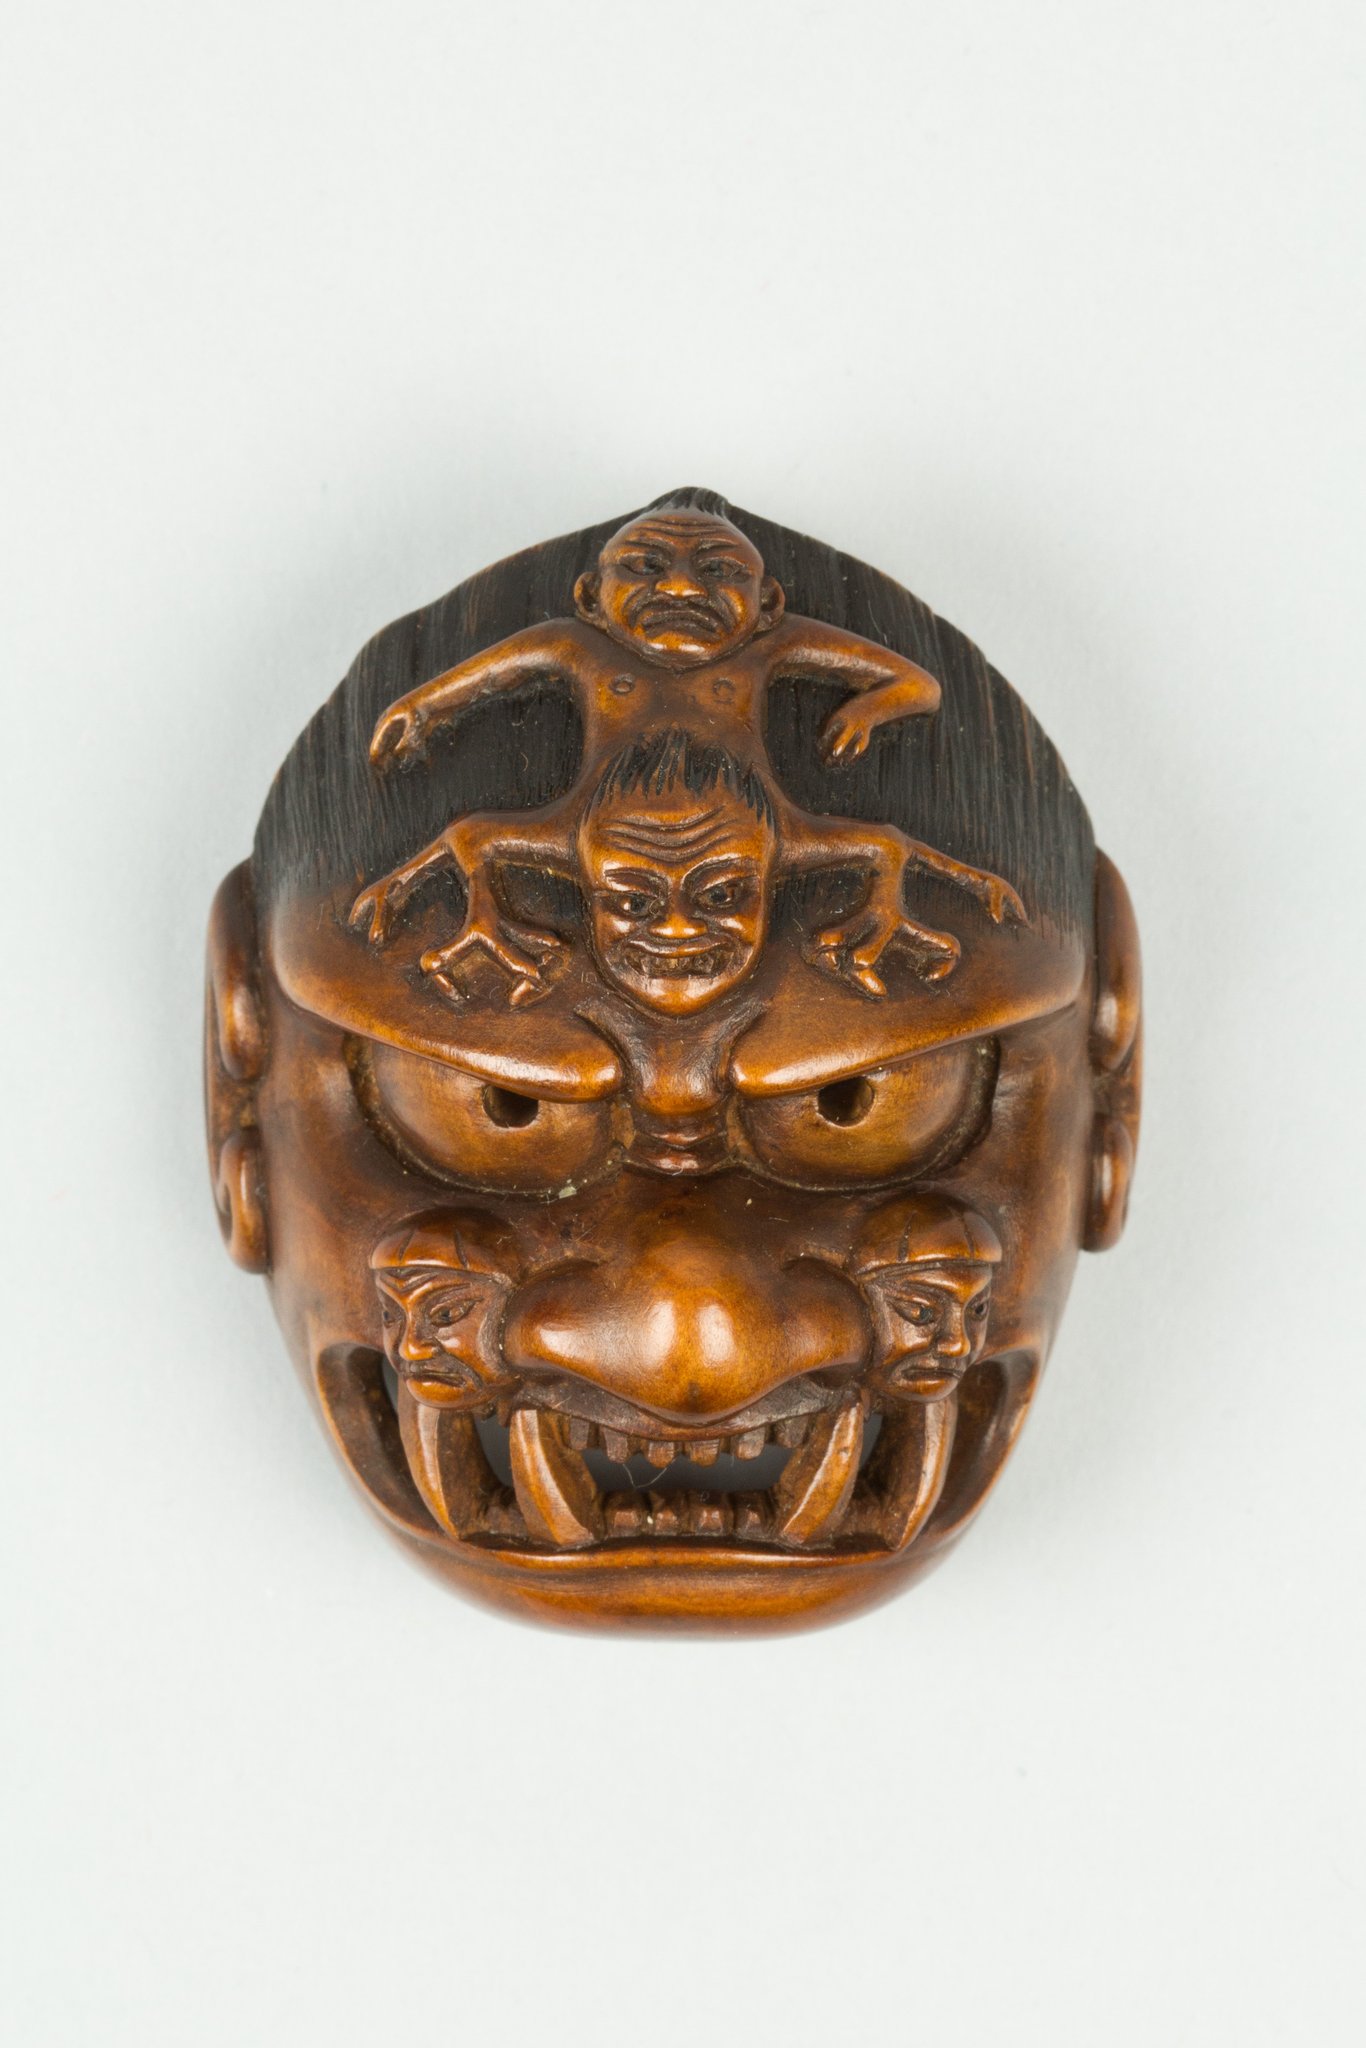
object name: netsuke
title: Netsuke of Grotesque Mask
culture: japanese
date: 1701-1800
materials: wood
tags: masks